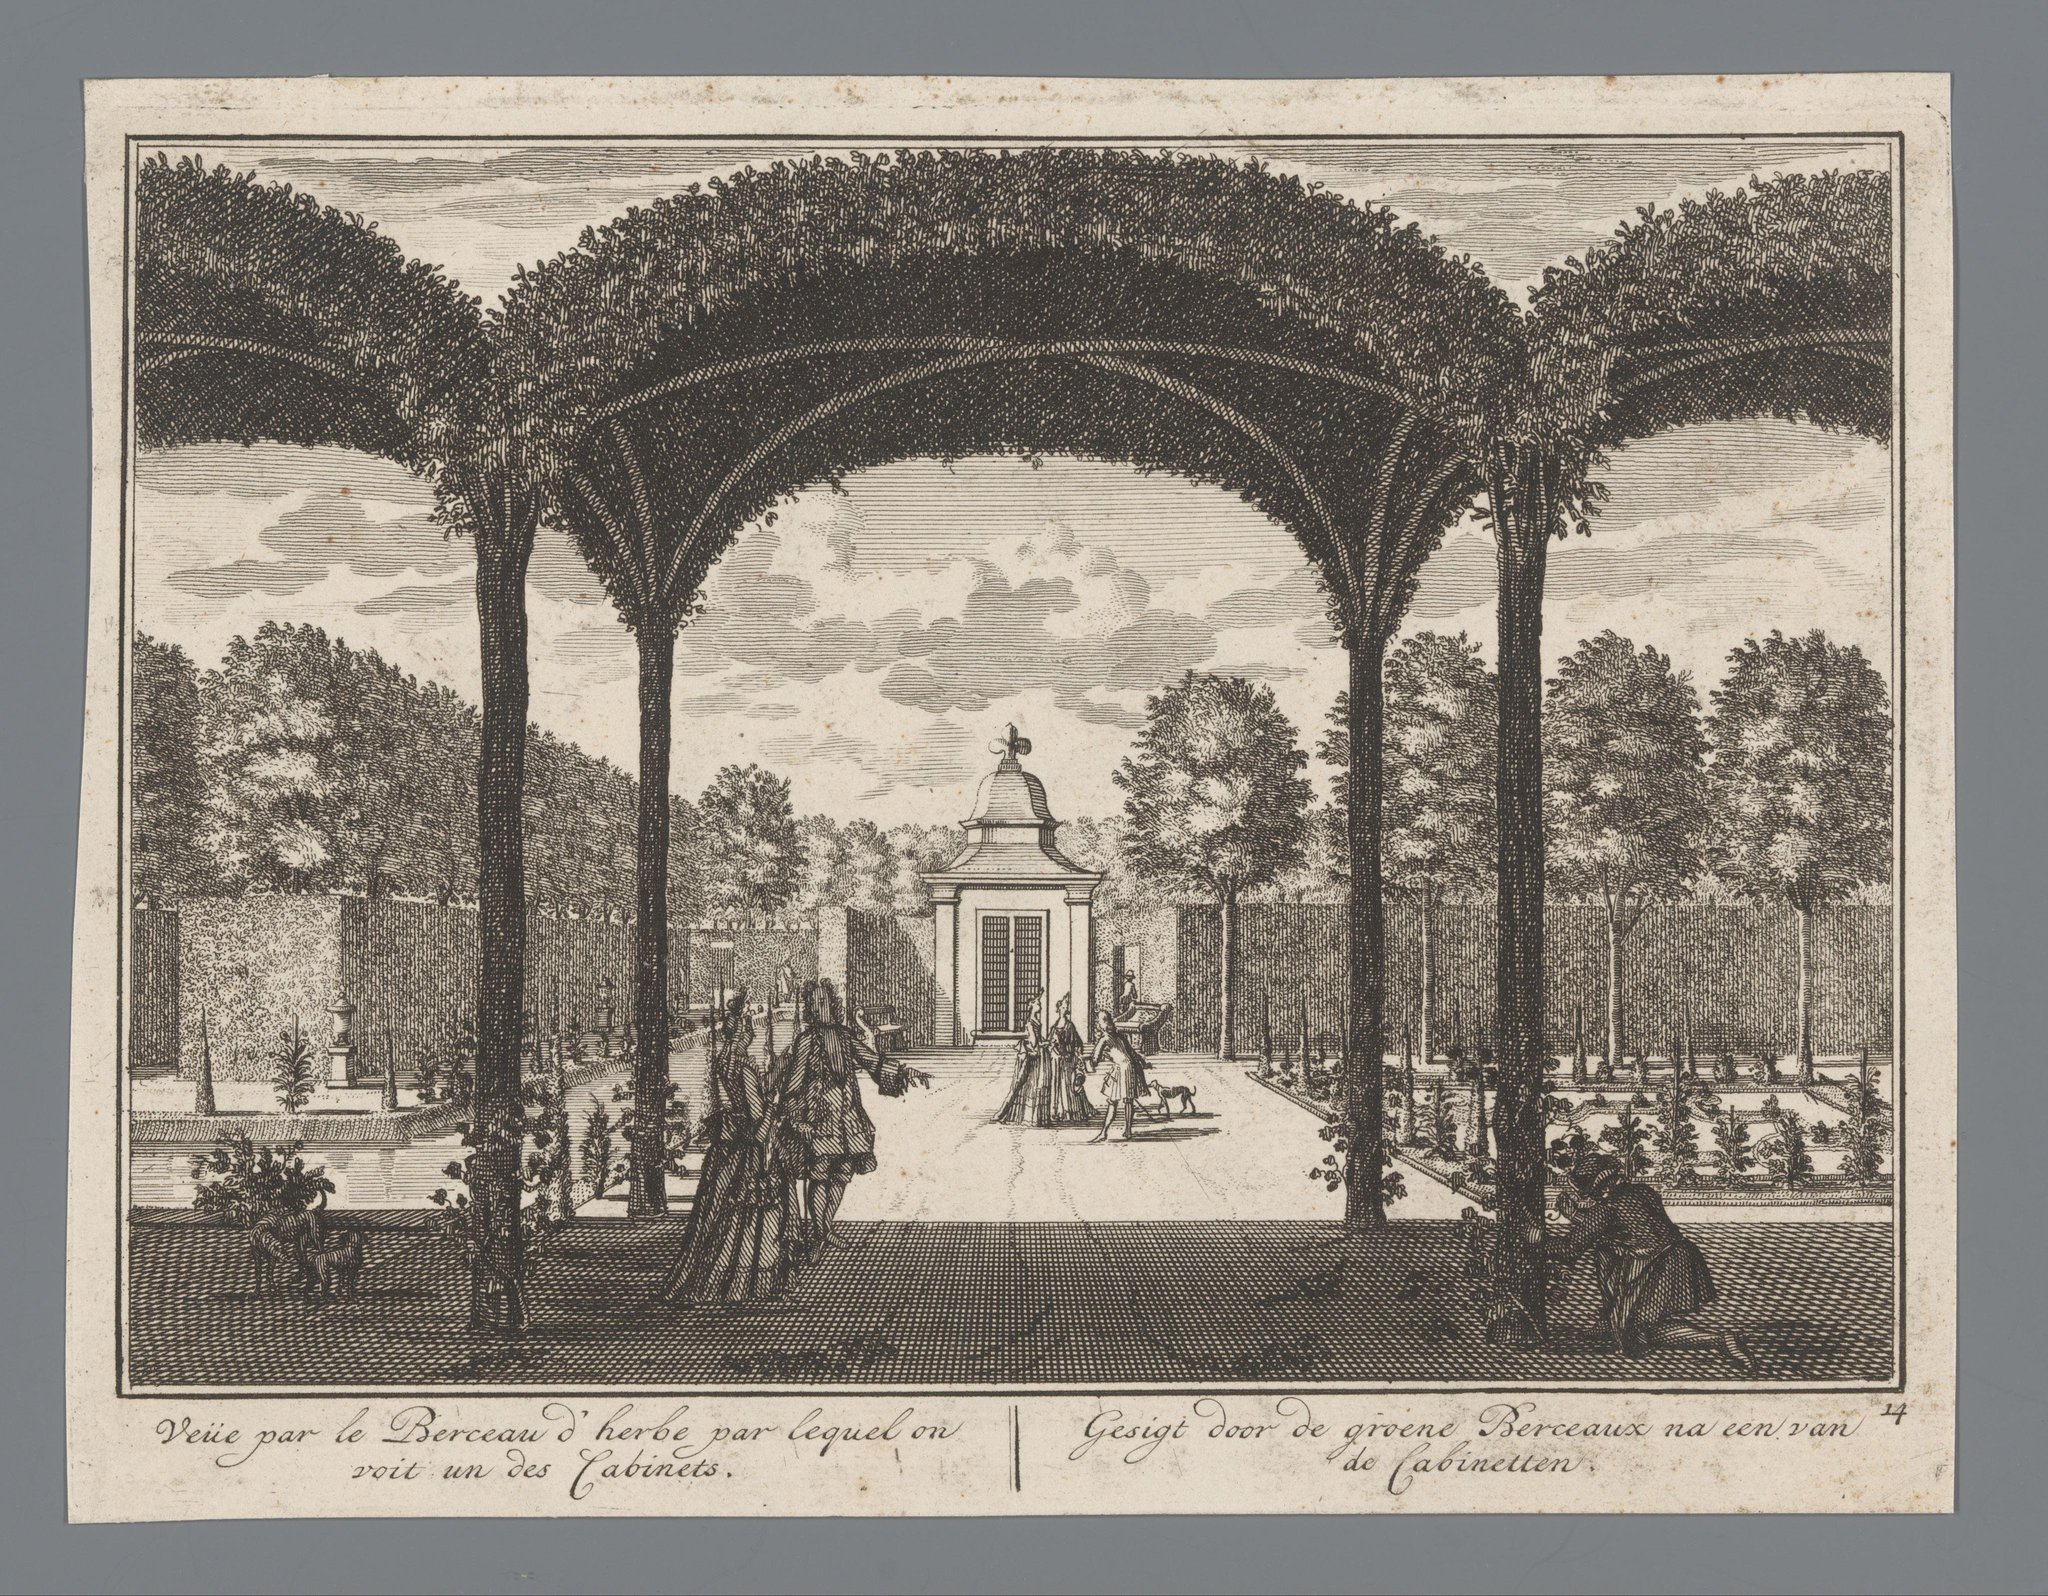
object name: print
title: Gezicht op een theehuis in de tuin van Slot Zeist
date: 1682-1726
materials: paper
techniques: etching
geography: amsterdam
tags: castle, landscape with tower or castle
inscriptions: collector's mark: Lugt 2233